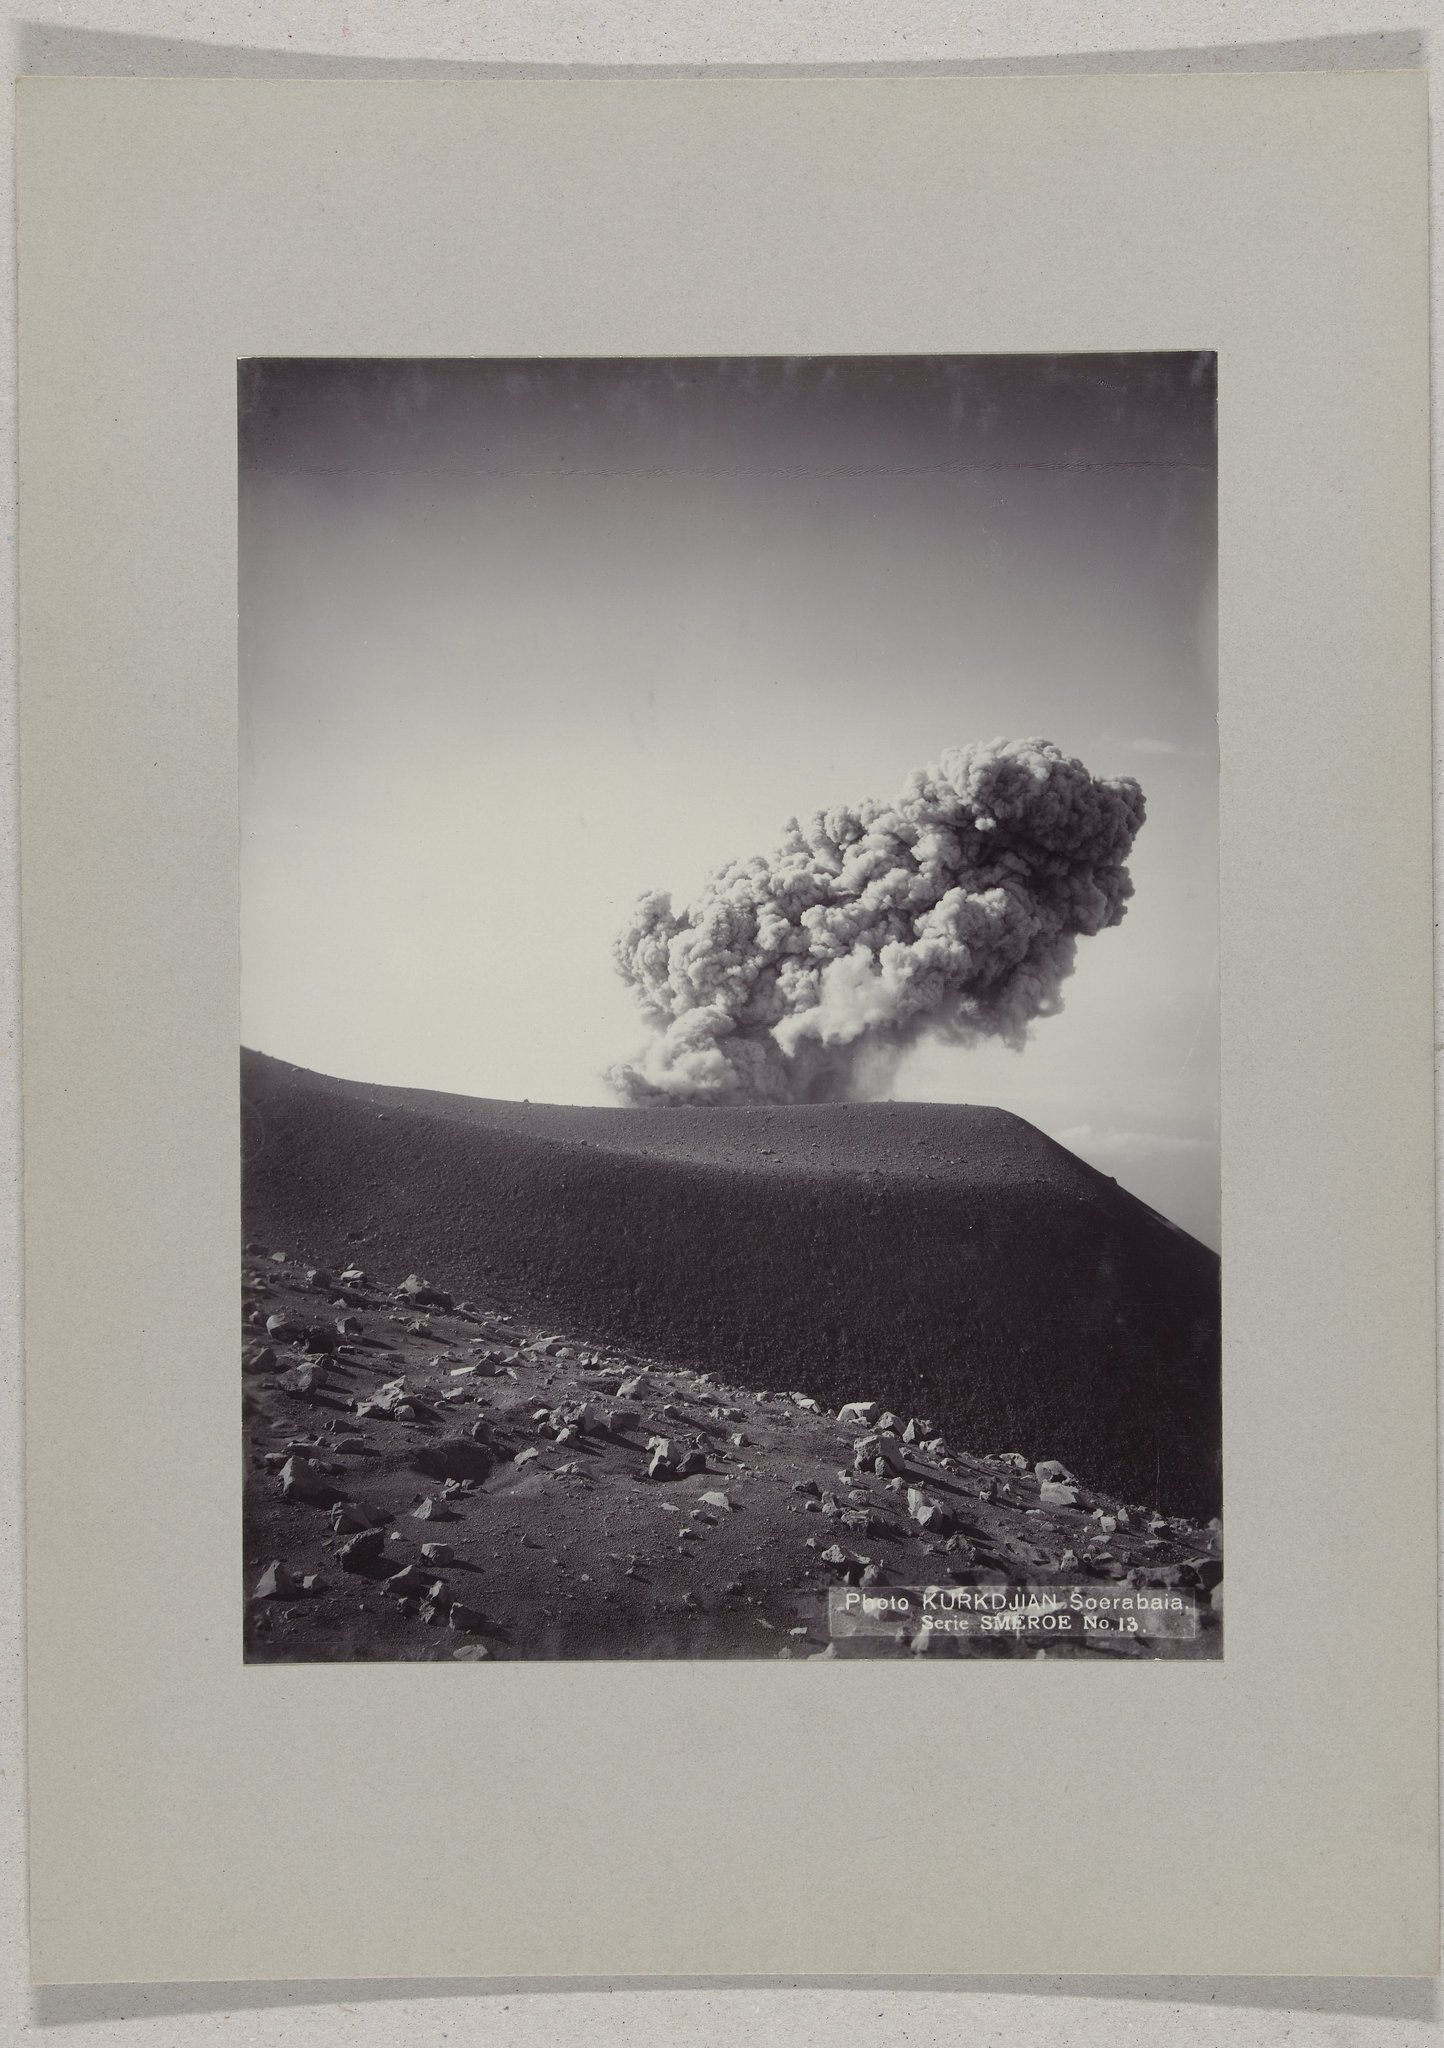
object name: photograph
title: Rokende vulkaan de Smeroe in het Tenggergebergte, Java, Nederlands-Indië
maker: onnes kurkdjian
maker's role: fotograaf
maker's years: 1851-1903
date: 1895-1915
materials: cardboard, paper, photographic support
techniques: gelatin silver print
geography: java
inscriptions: name: ‘Photo Kurkdjian Soerabaia / Serie Smeroe No. 13’, number: ‘94’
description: Rokende vulkaan de Smeroe in het Tenggergebergte, Java, Nederlands-Indië.